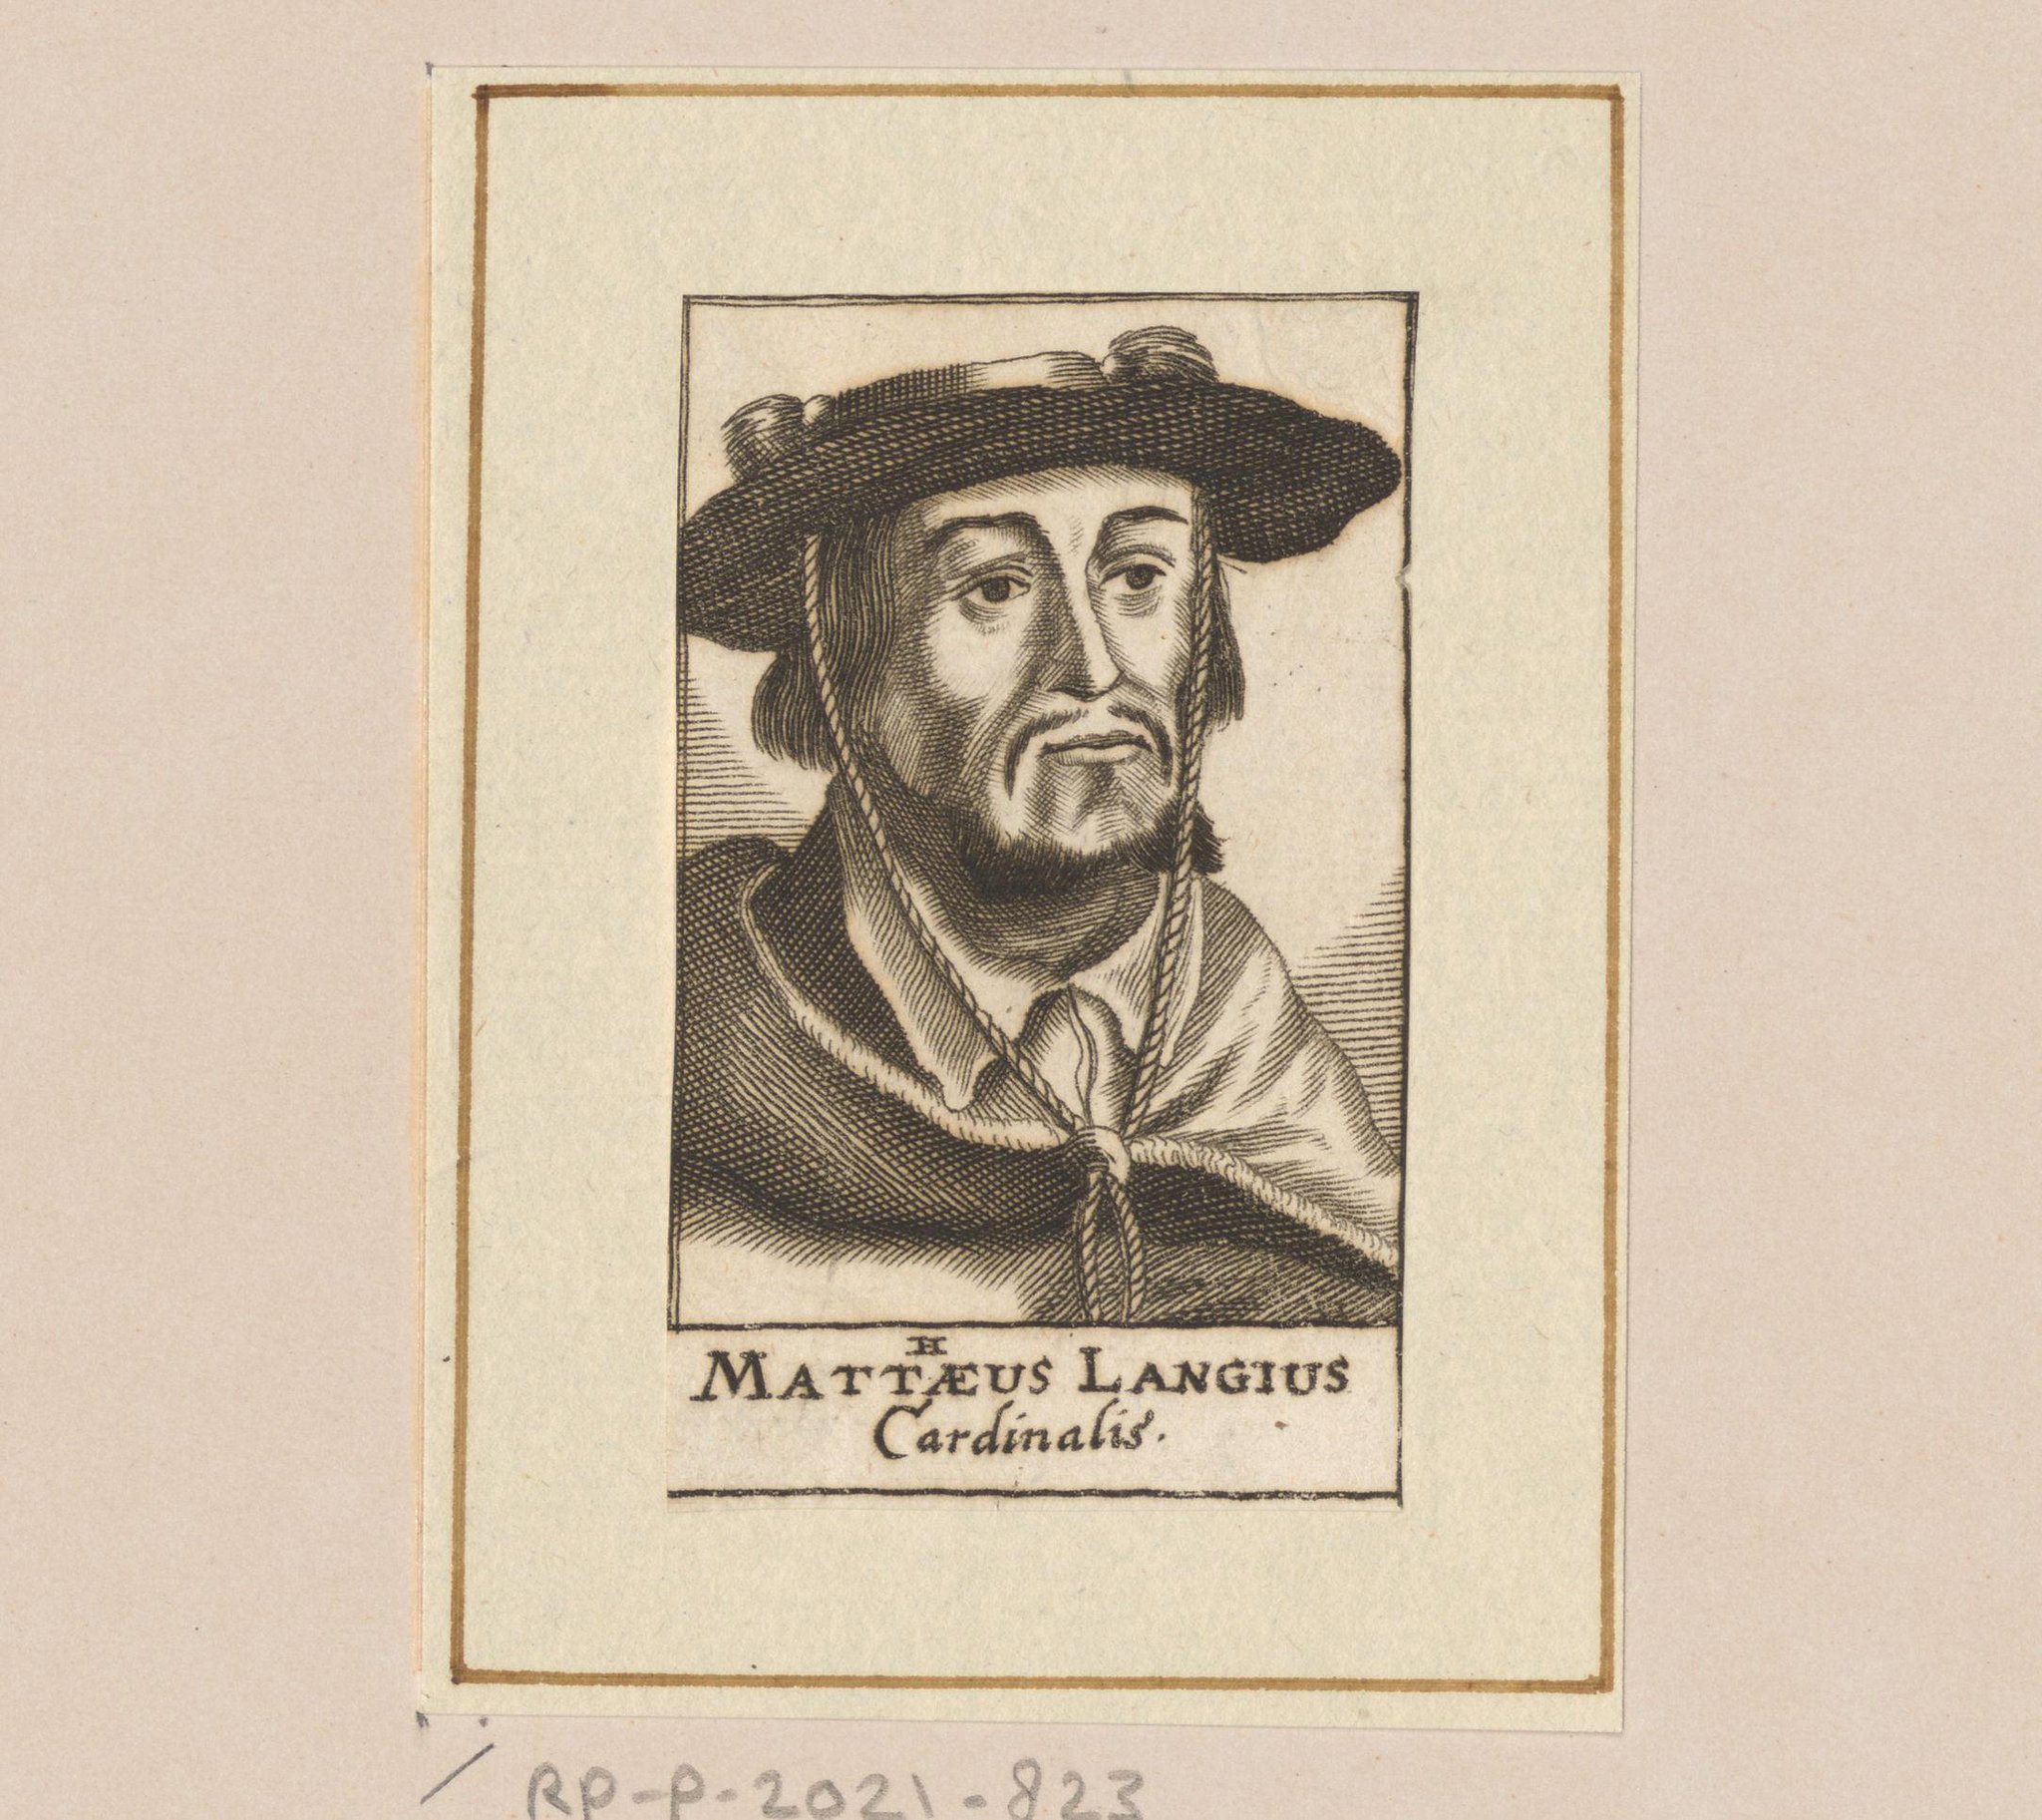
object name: book illustration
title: Portret van Matthäus Lang von Wellenburg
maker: Anonymous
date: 1688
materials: paper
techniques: engraving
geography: germany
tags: matthäus lang von wellenburg, cardinal, historical persons, insignia of cardinal, e.g. hat, mantle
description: Prent waarschijnlijk uit: Freher, Paul. Theatrum virorum eruditione clarorum. Neurenberg: Johann Hoffmann, 1688.